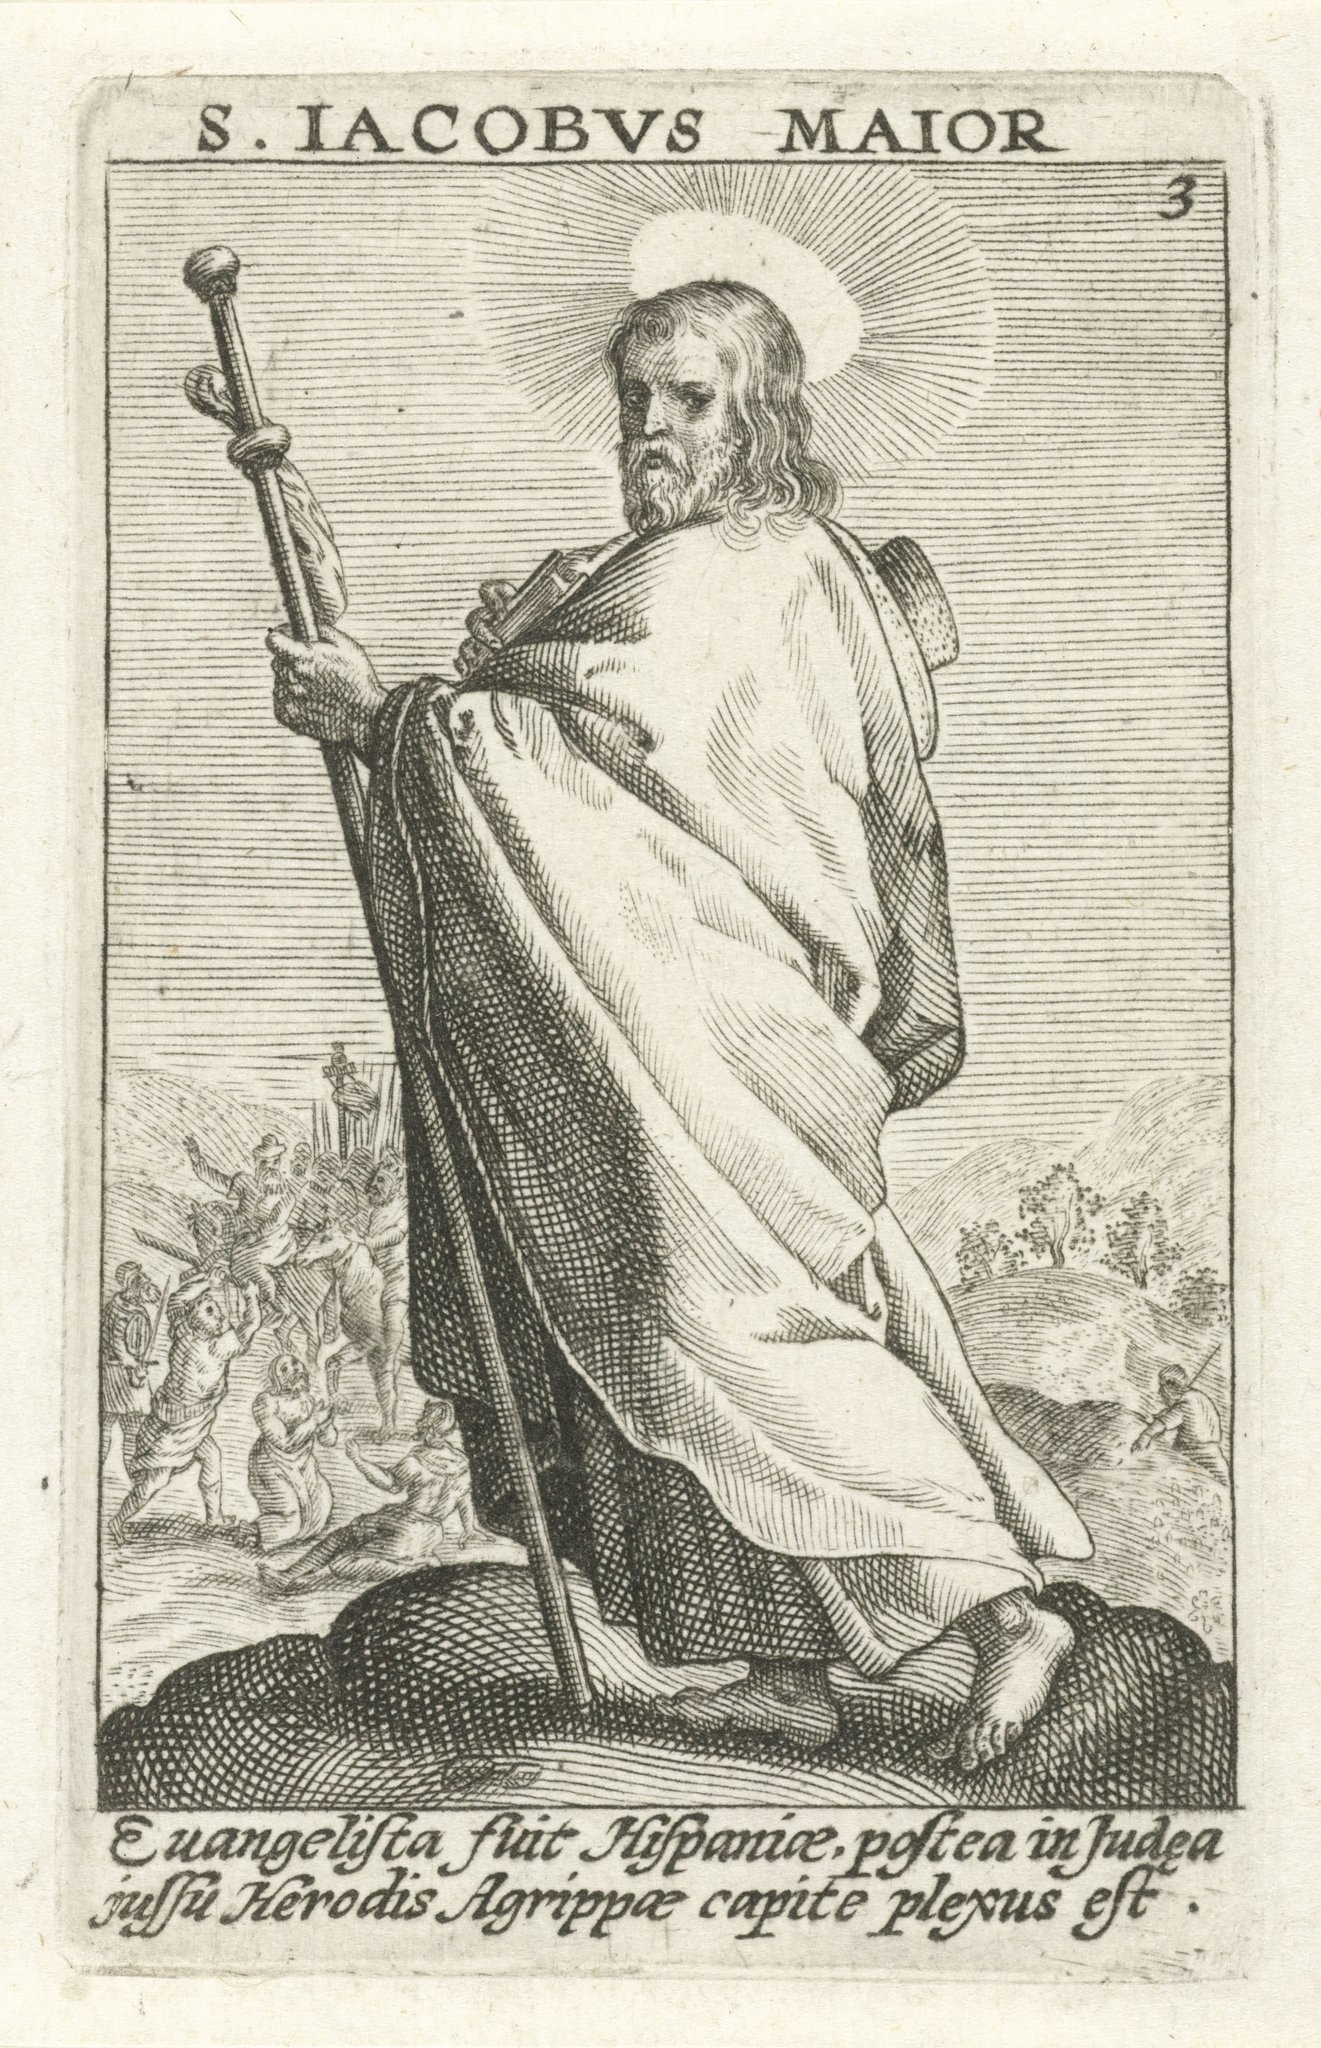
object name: print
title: XII. Apostolos.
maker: crispijn van de passe (i)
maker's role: draughtsman, print maker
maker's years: 1564-1637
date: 1574-1637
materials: paper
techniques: engraving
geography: cologne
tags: beheading of james, the apostle james the great; possible attributes: book, pilgrim's cloak, hat, shell, staff, and wallet, scroll, sword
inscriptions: collector's mark: Lugt 240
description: De apostel Jakobus de Meerdere, ten voeten uit, een hoed op zijn rug en een wandelstok in de hand. Op de achtergrond zijn onthoofding. In de marge een onderschrift in het Latijn. Prent uit een serie met de twaalf apostelen.